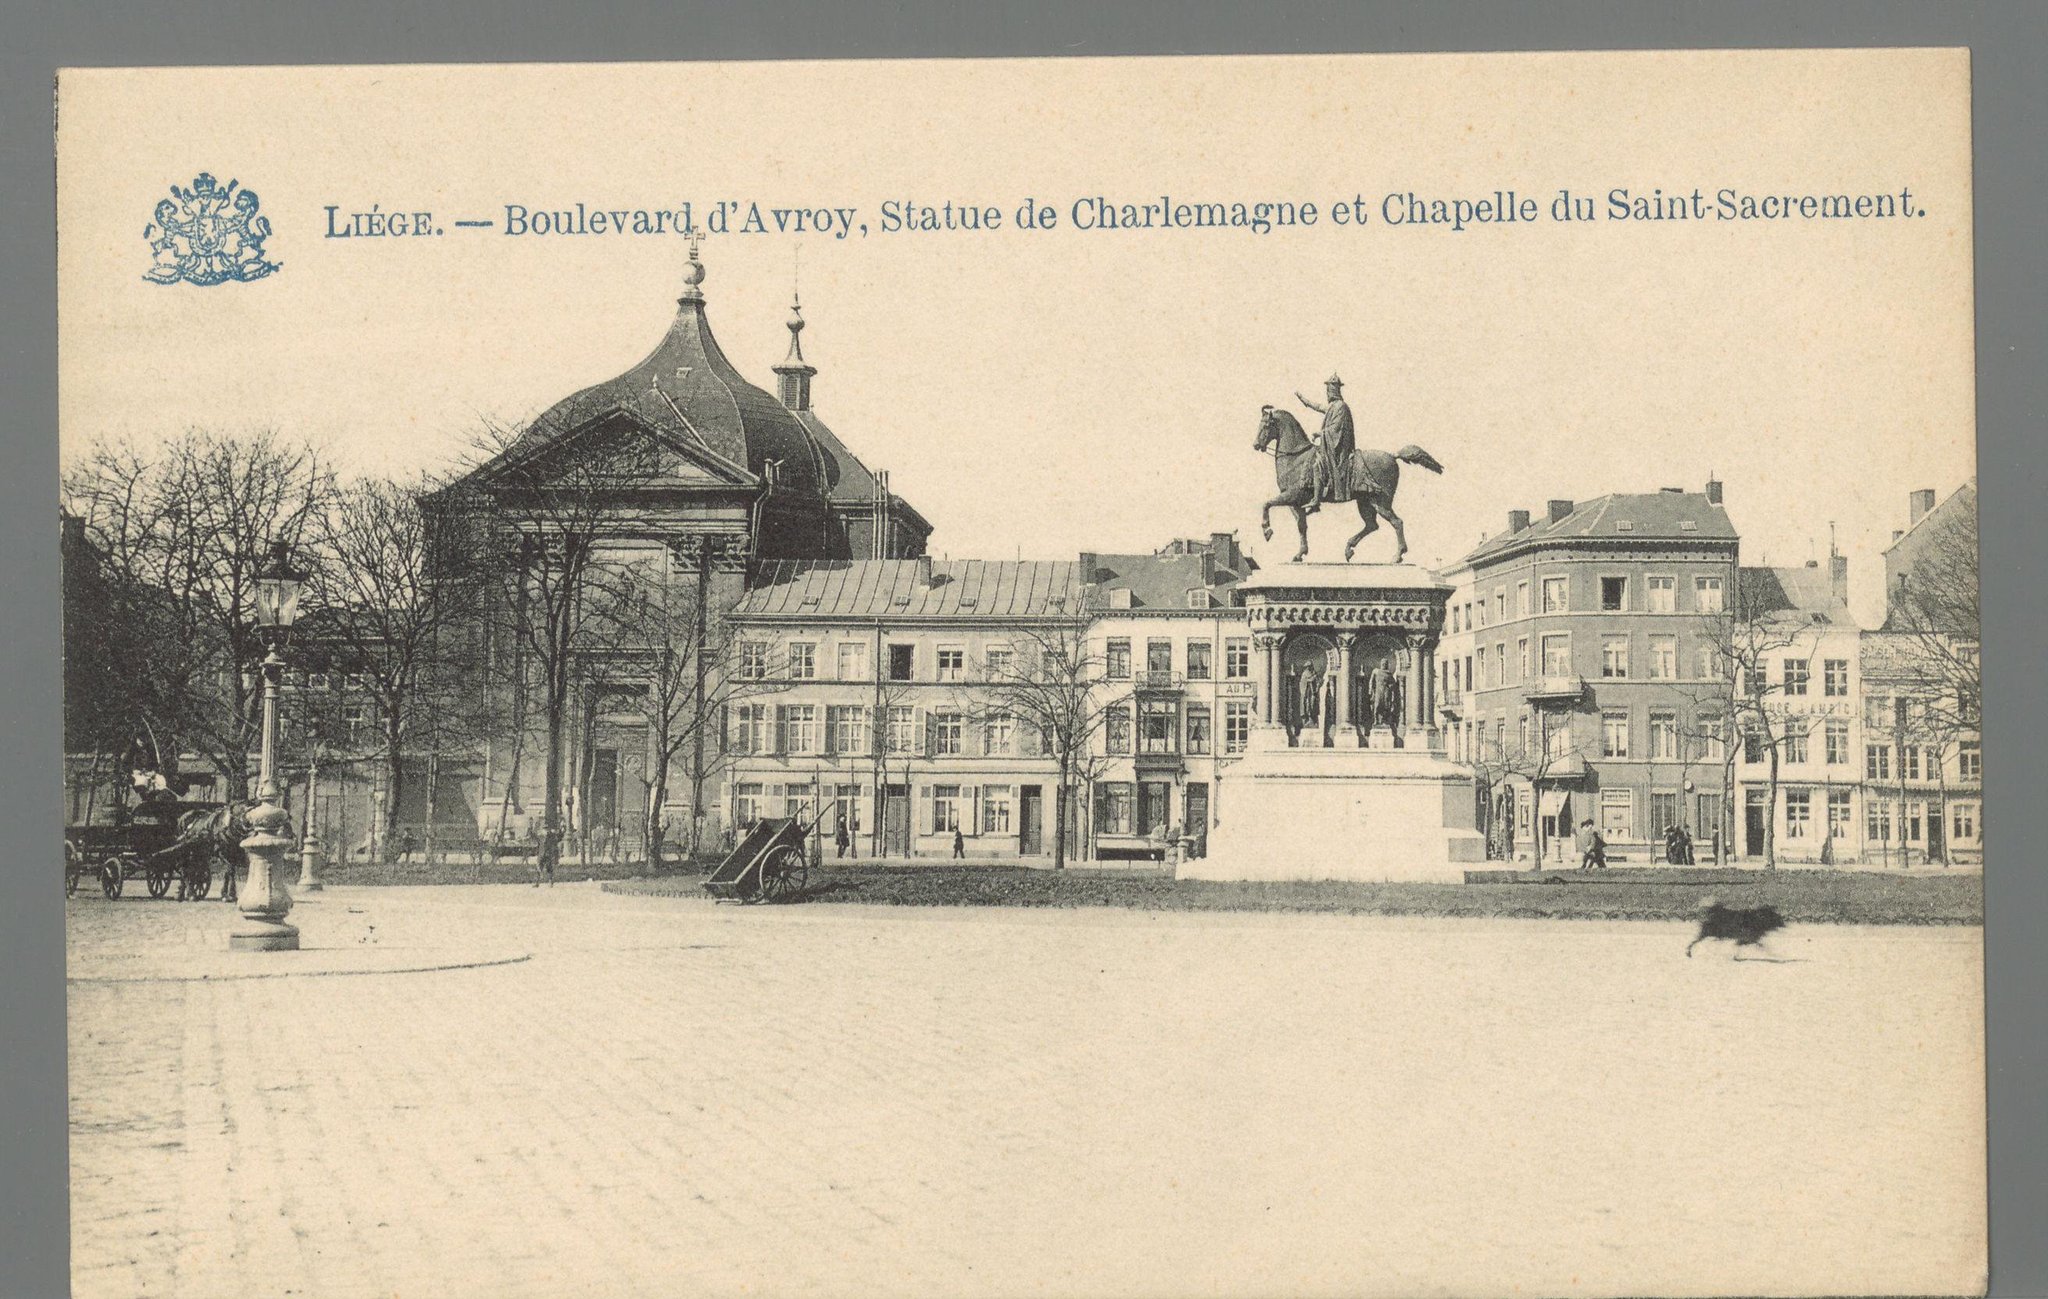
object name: photomechanical print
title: Liège. Boulevard d'Avroy, Statue de Charlemagne et Chapelle du Saint-Sacrement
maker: Anonymous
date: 1892-1906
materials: cardboard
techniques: photograph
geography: liège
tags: church (exterior), monument, statue, square, place, circus, etc. (+ city(-scape) with figures, staffage), liège